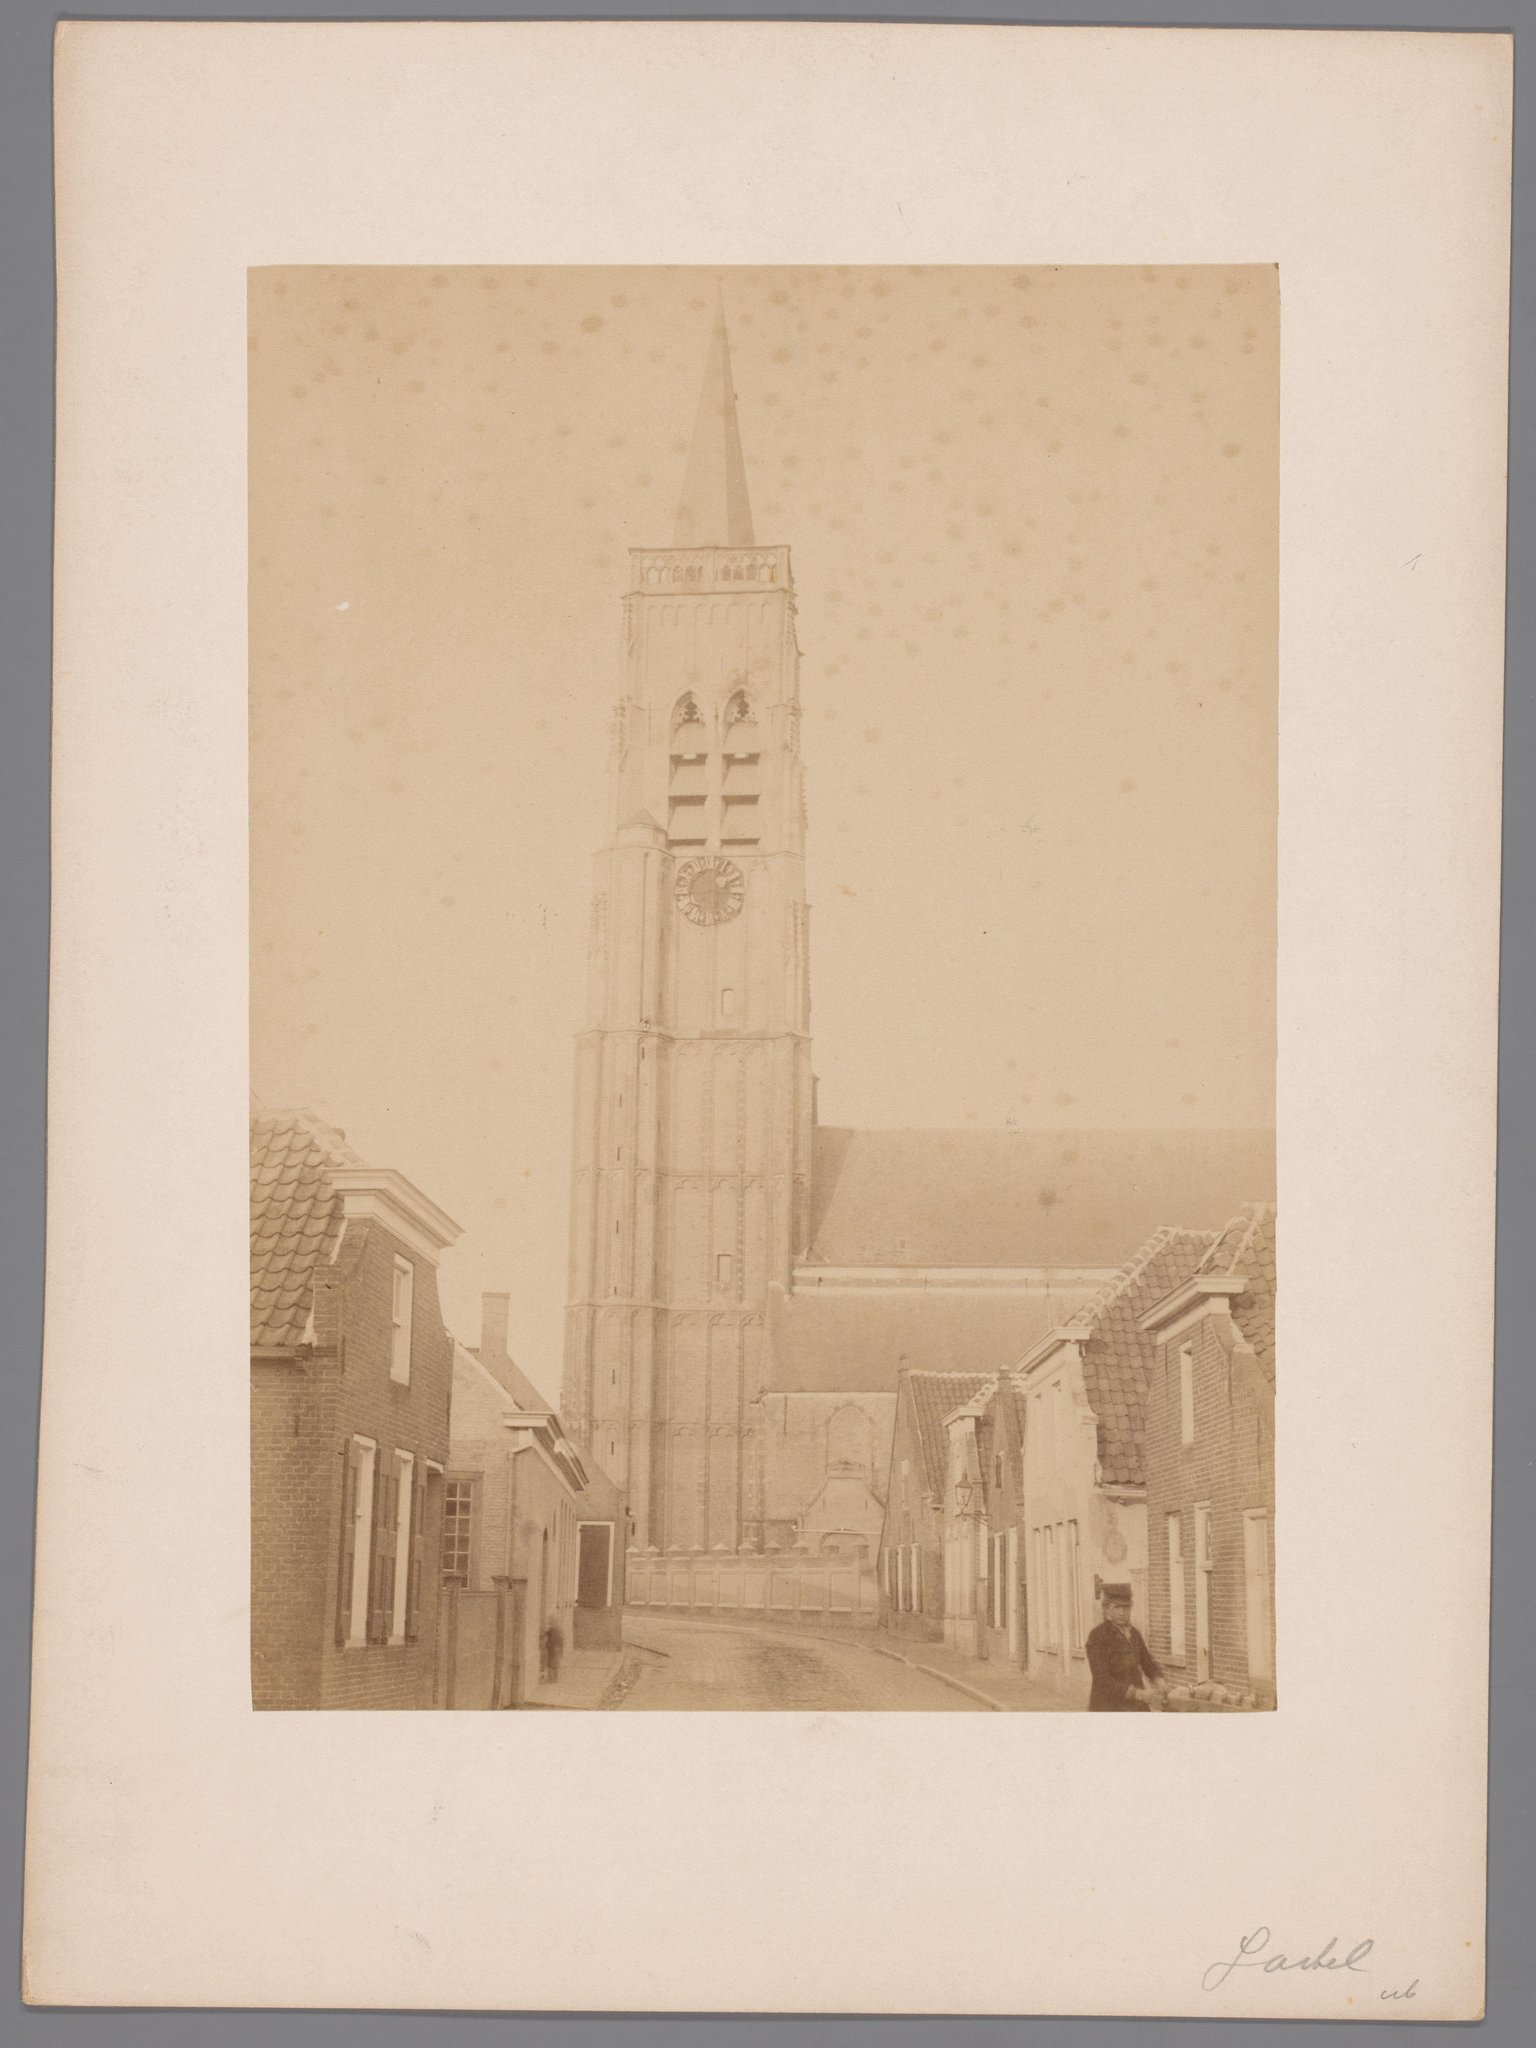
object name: photograph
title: Gezicht op de Sint-Laurentiuskerk te Oud Gastel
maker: anoniem (monumentenzorg)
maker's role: fotograaf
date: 1899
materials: cardboard, photographic support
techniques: albumen print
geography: oud gastel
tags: parts of church exterior and annexes: tower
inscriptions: annotation: ‘Toren van de R.K. Kerk te Gastel (N.B.)/ Jan 1899’, annotation: ‘Gastel’